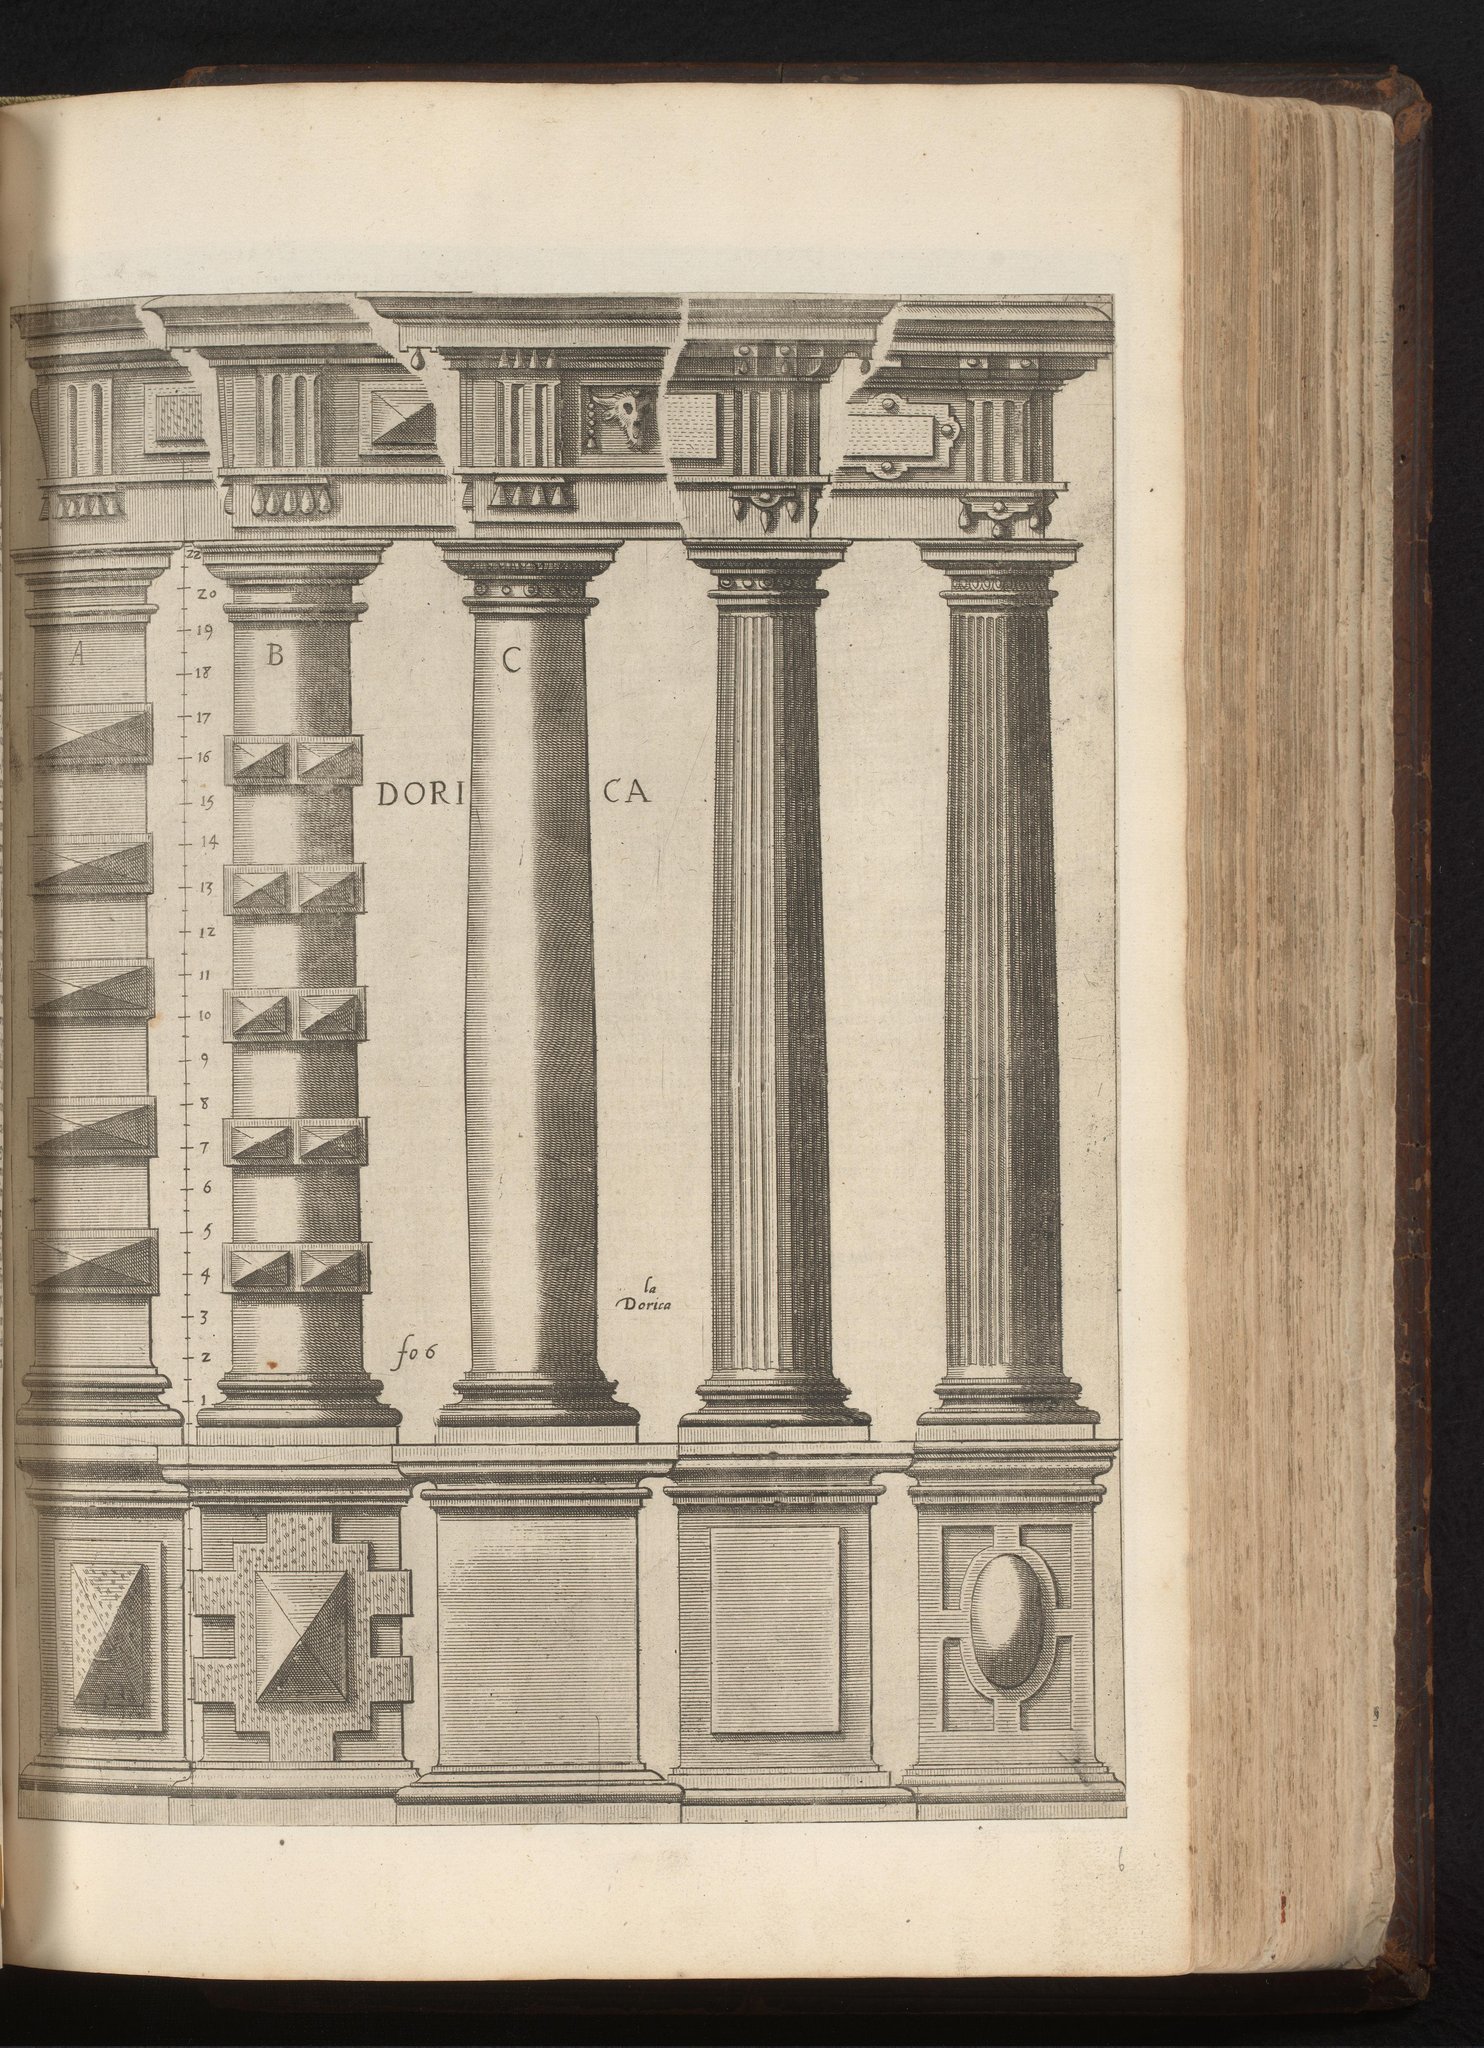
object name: print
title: Dorische zuilen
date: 1581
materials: paper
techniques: engraving, etching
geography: antwerp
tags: doric order ~ architecture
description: Prent uit: Vredeman de Vries, Hans. Architectura oder Bauung der Antiquen auss dem Vitruvius, waellches sein funff Collummen orden, (...). Antwerpen: Gerard de Jode en Gerard Smits, 1581. Prent eerder verschenen in de 1577-editie.